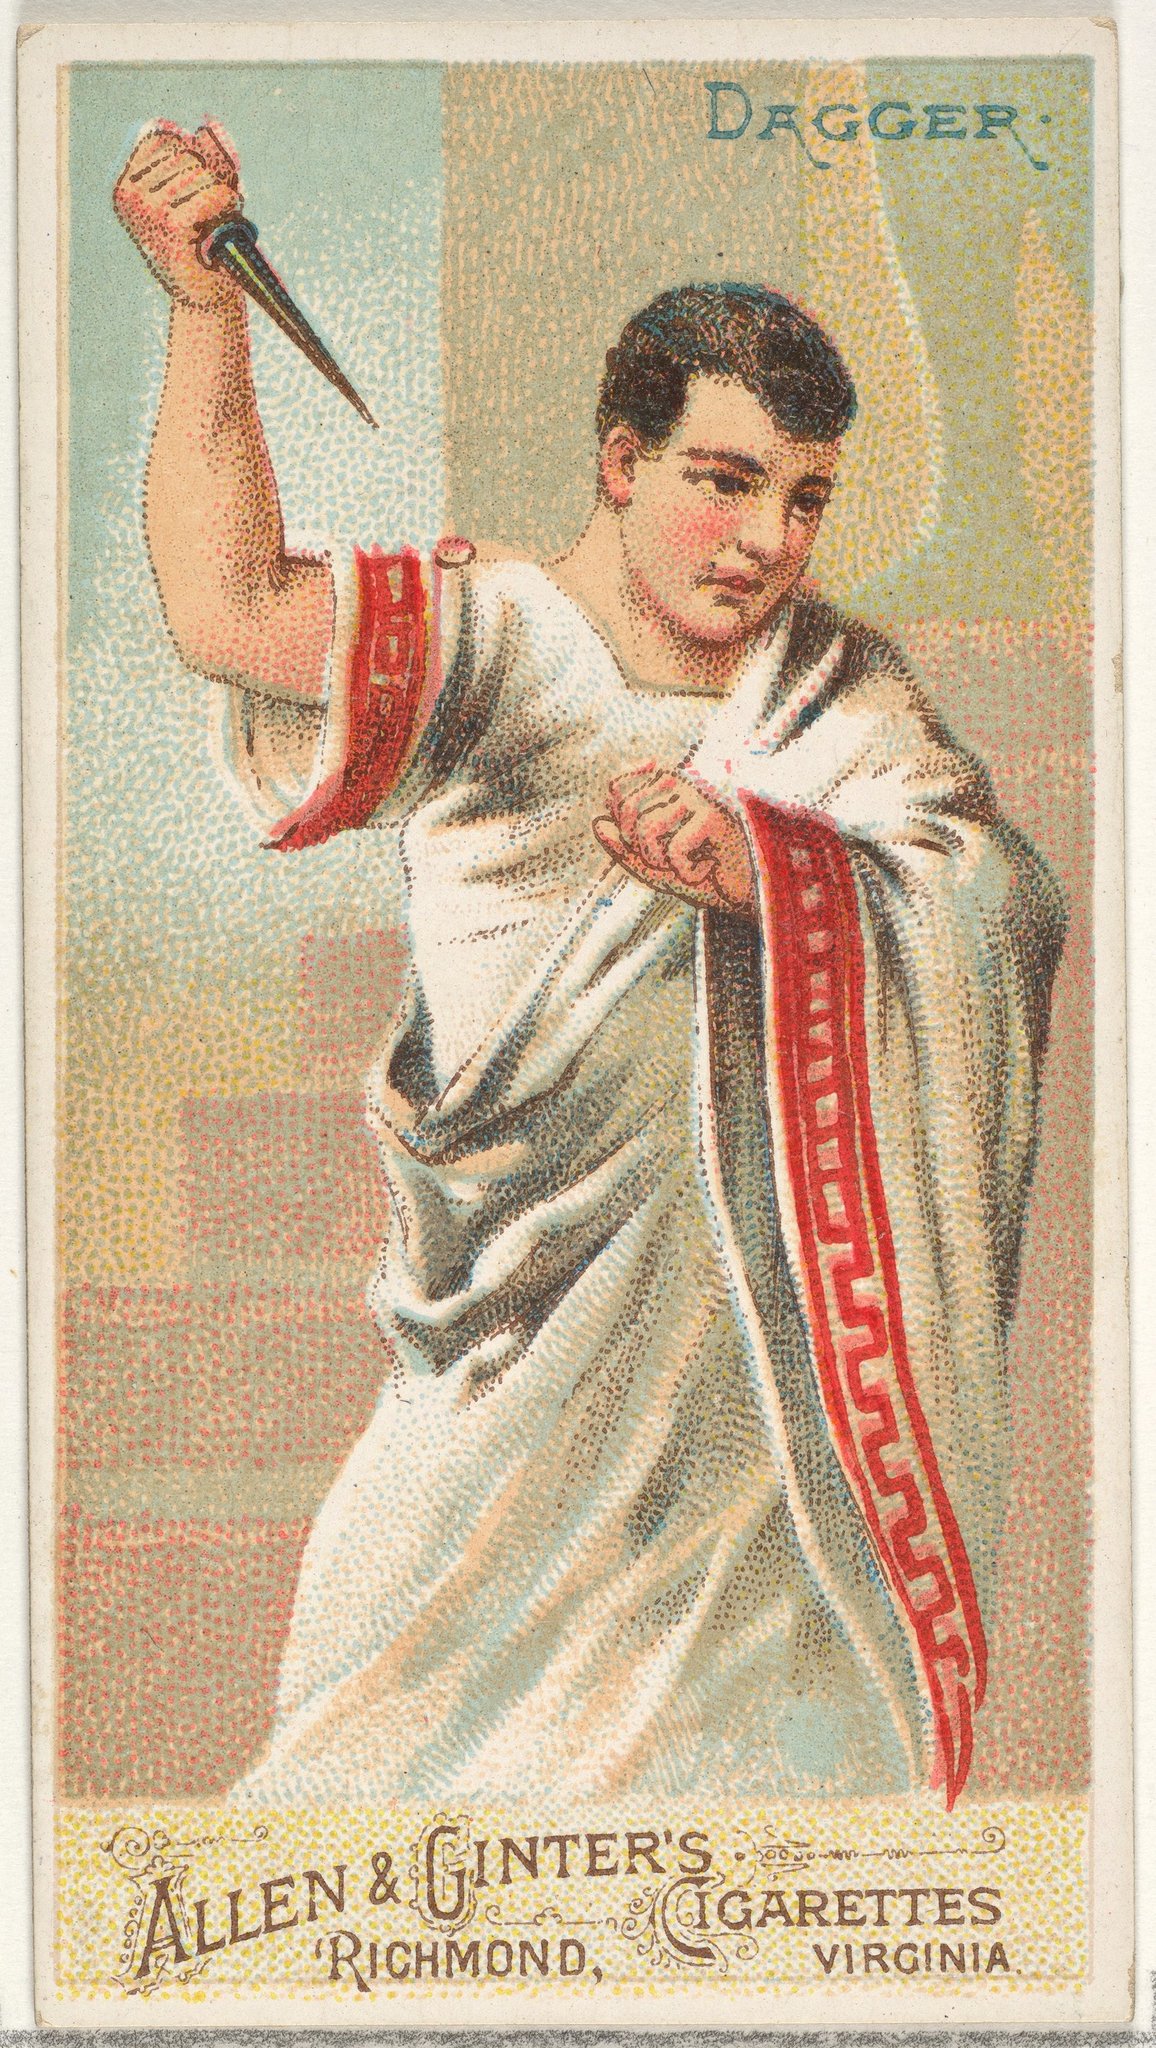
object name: print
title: Dagger, from the Arms of All Nations series (N3) for Allen & Ginter Cigarettes Brands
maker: allen & ginter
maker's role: publisher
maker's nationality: american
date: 1887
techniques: color lithograph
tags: daggers,men